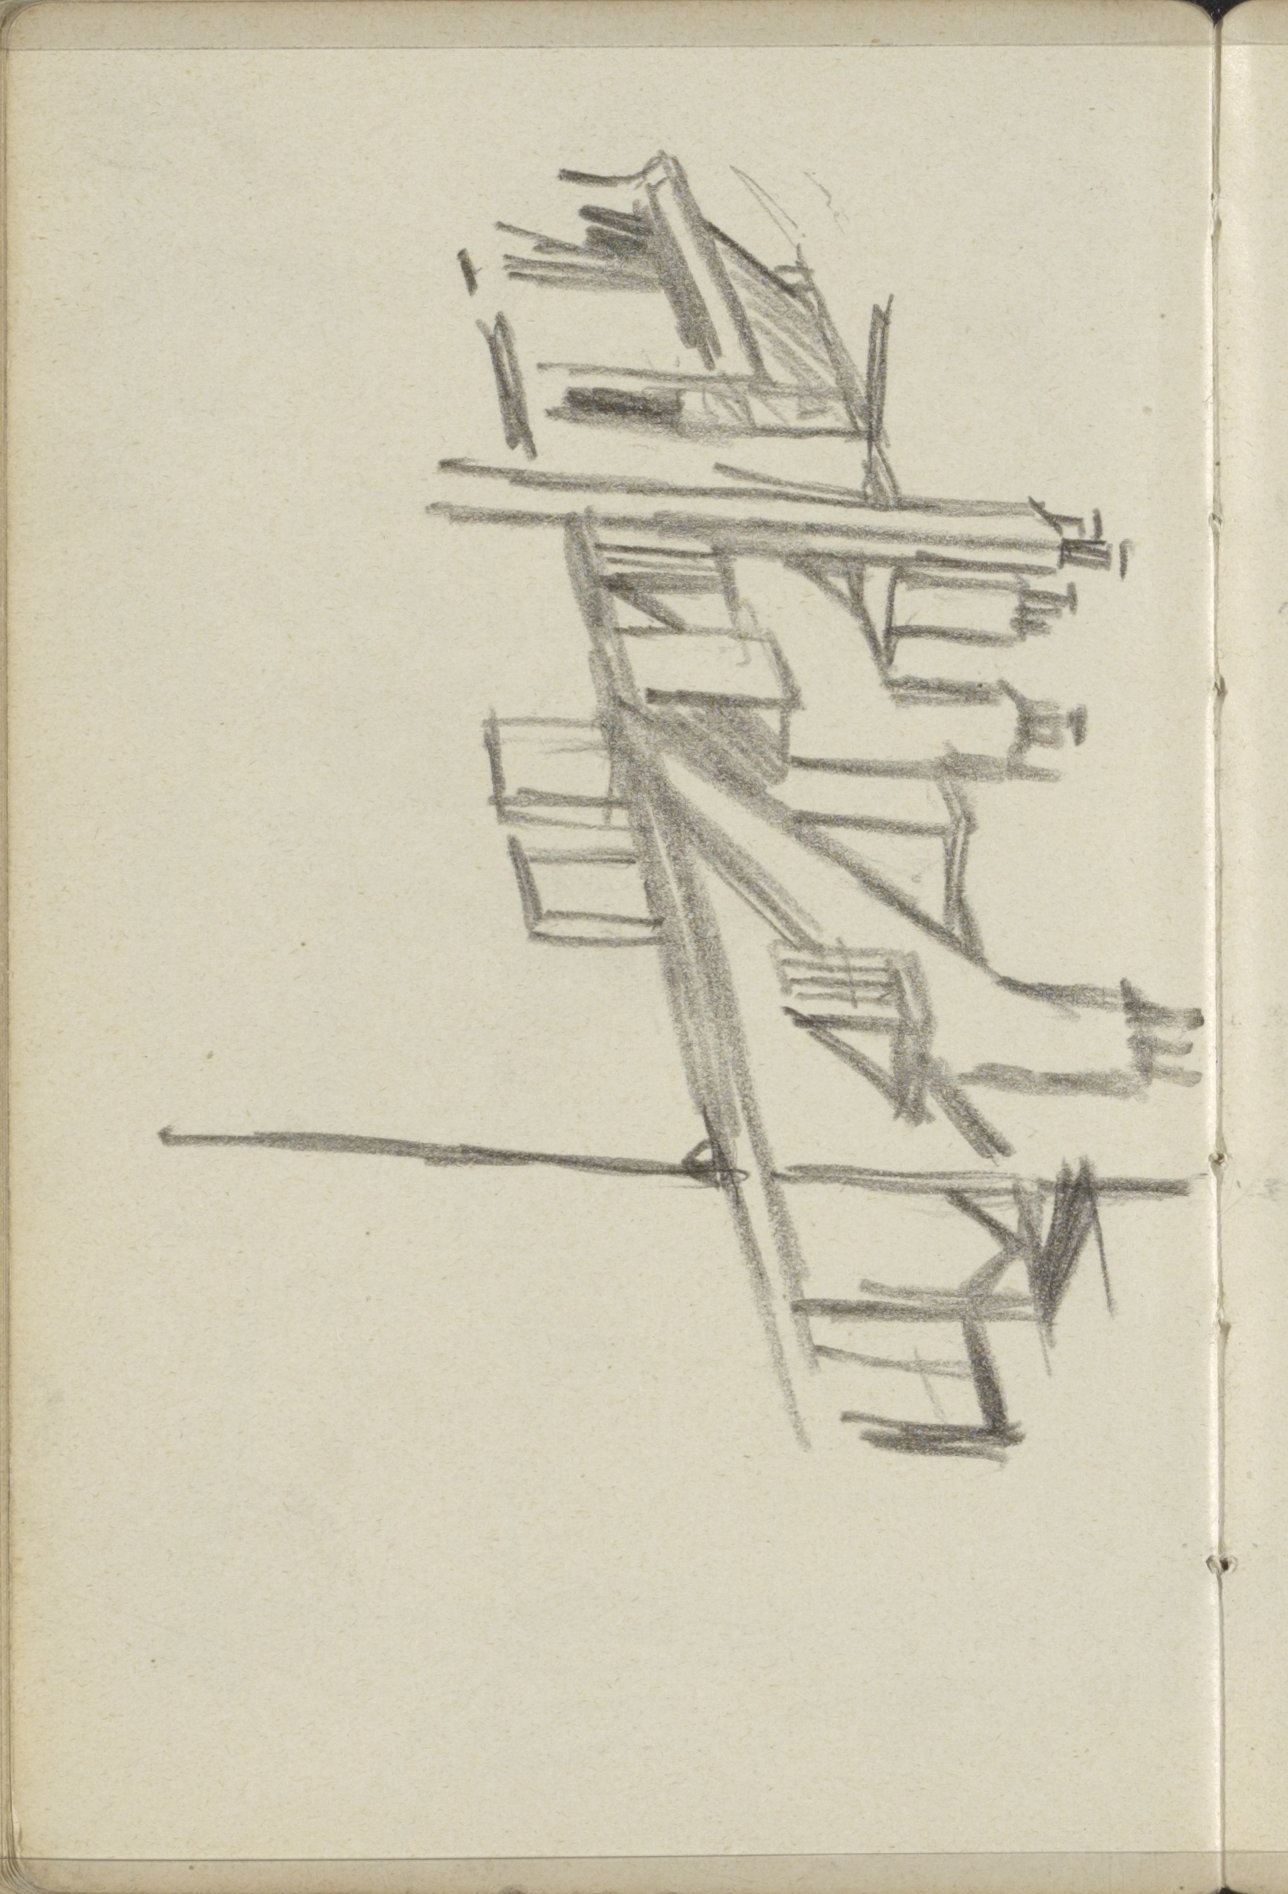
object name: sketchbook leaf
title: Daken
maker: george hendrik breitner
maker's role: draughtsman, painter, print maker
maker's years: 1857-1923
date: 1910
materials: chalk, paper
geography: amsterdam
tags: roof (of house or building), civic architecture; edifices; dwellings, amsterdam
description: Pagina 85 uit een schetsboek met 45 bladen.